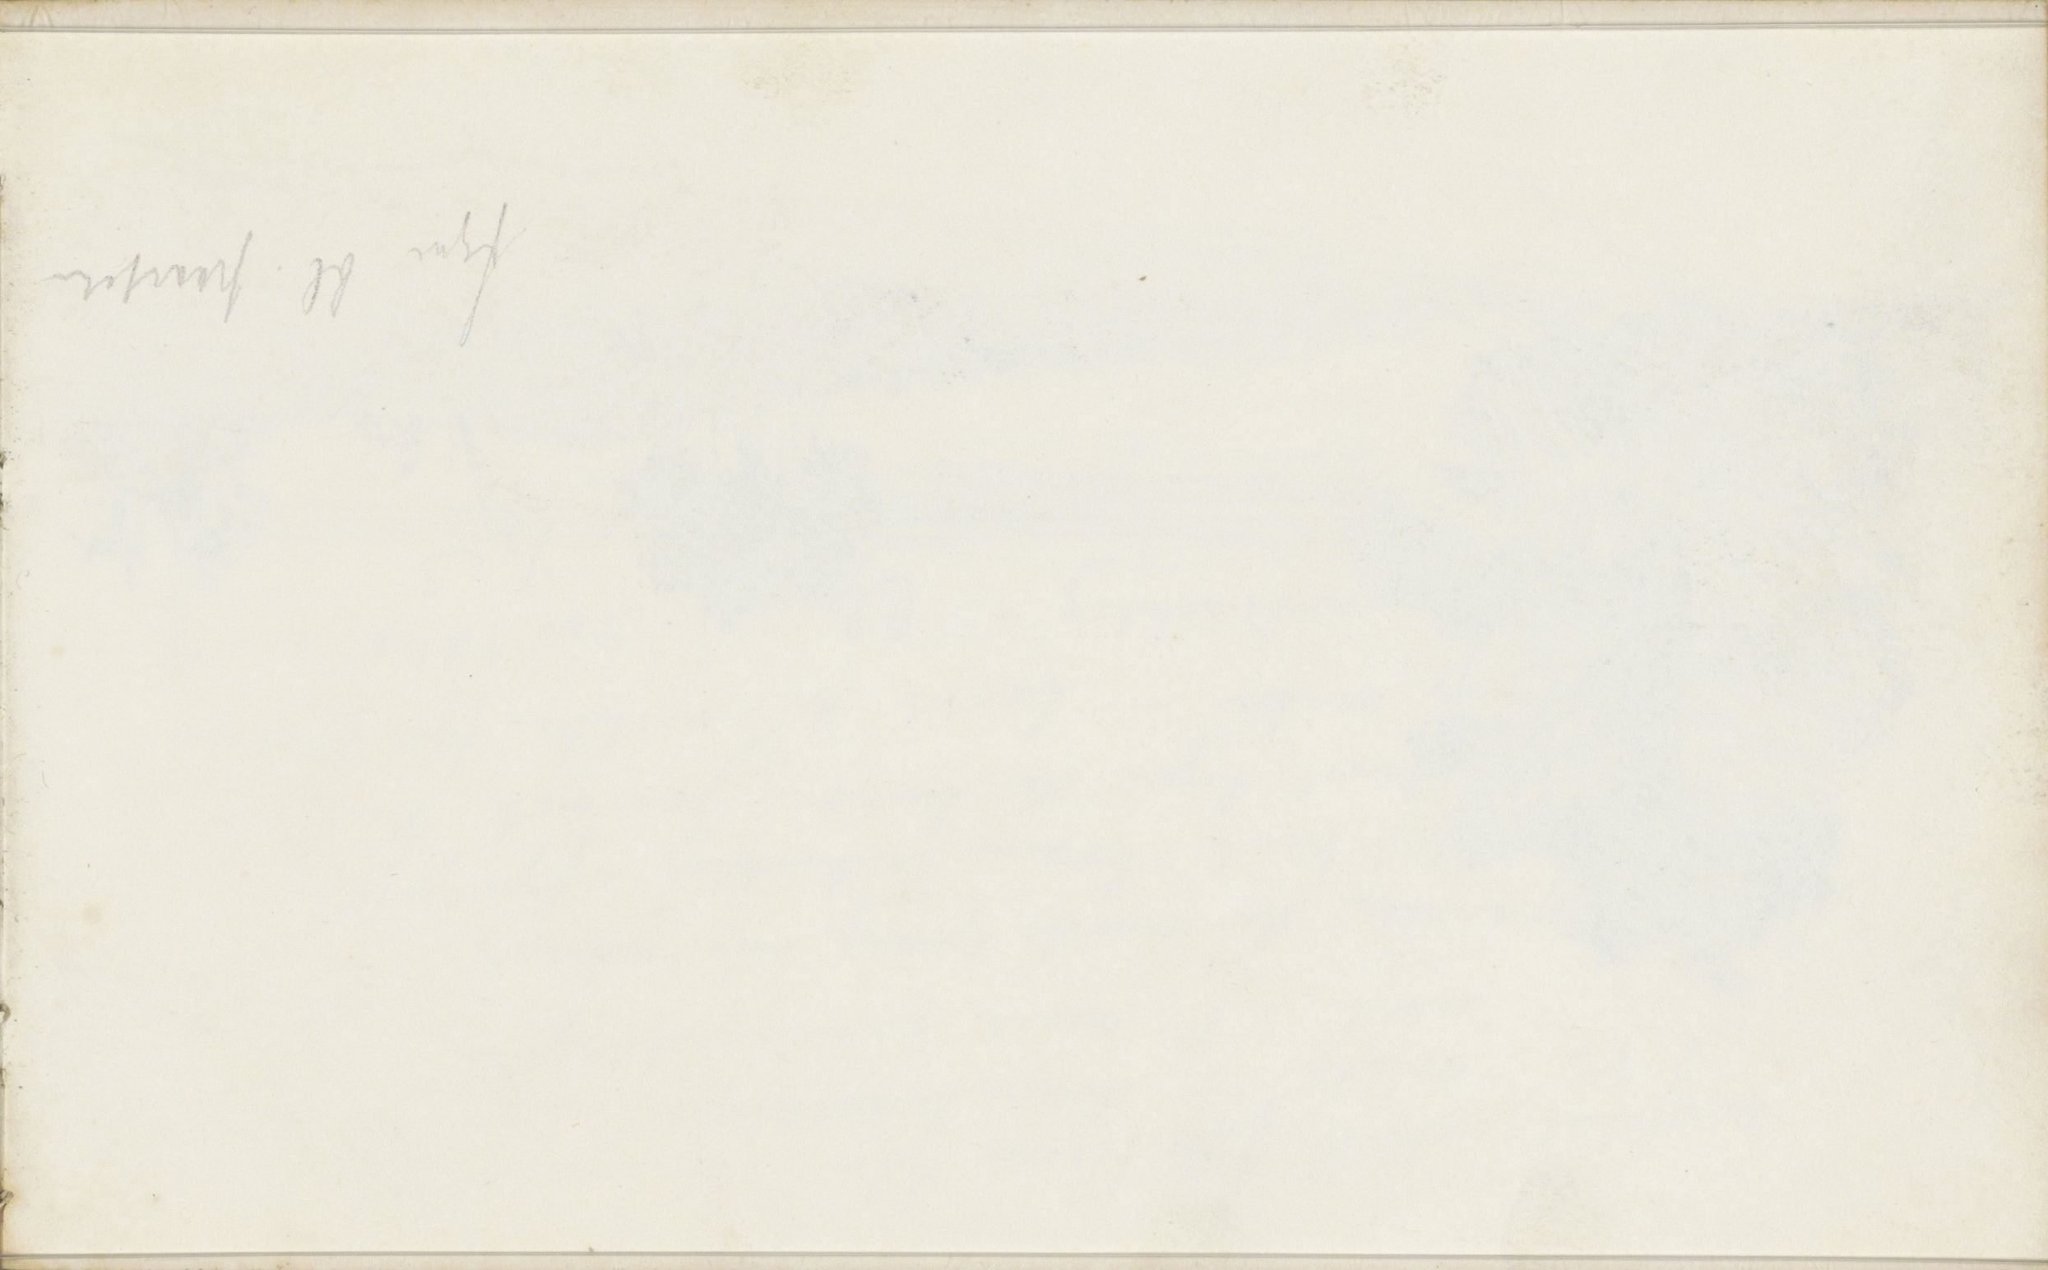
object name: sketchbook leaf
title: Notities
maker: johannes tavenraat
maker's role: draughtsman, painter, print maker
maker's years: 1809-1881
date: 1840-1841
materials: paper, pencil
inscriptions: kleurnotitie, handgeschreven: de notities verwijzen naar de schets op pagina 38 verso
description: Blad 39 recto uit een schetsboek met 41 bladen.